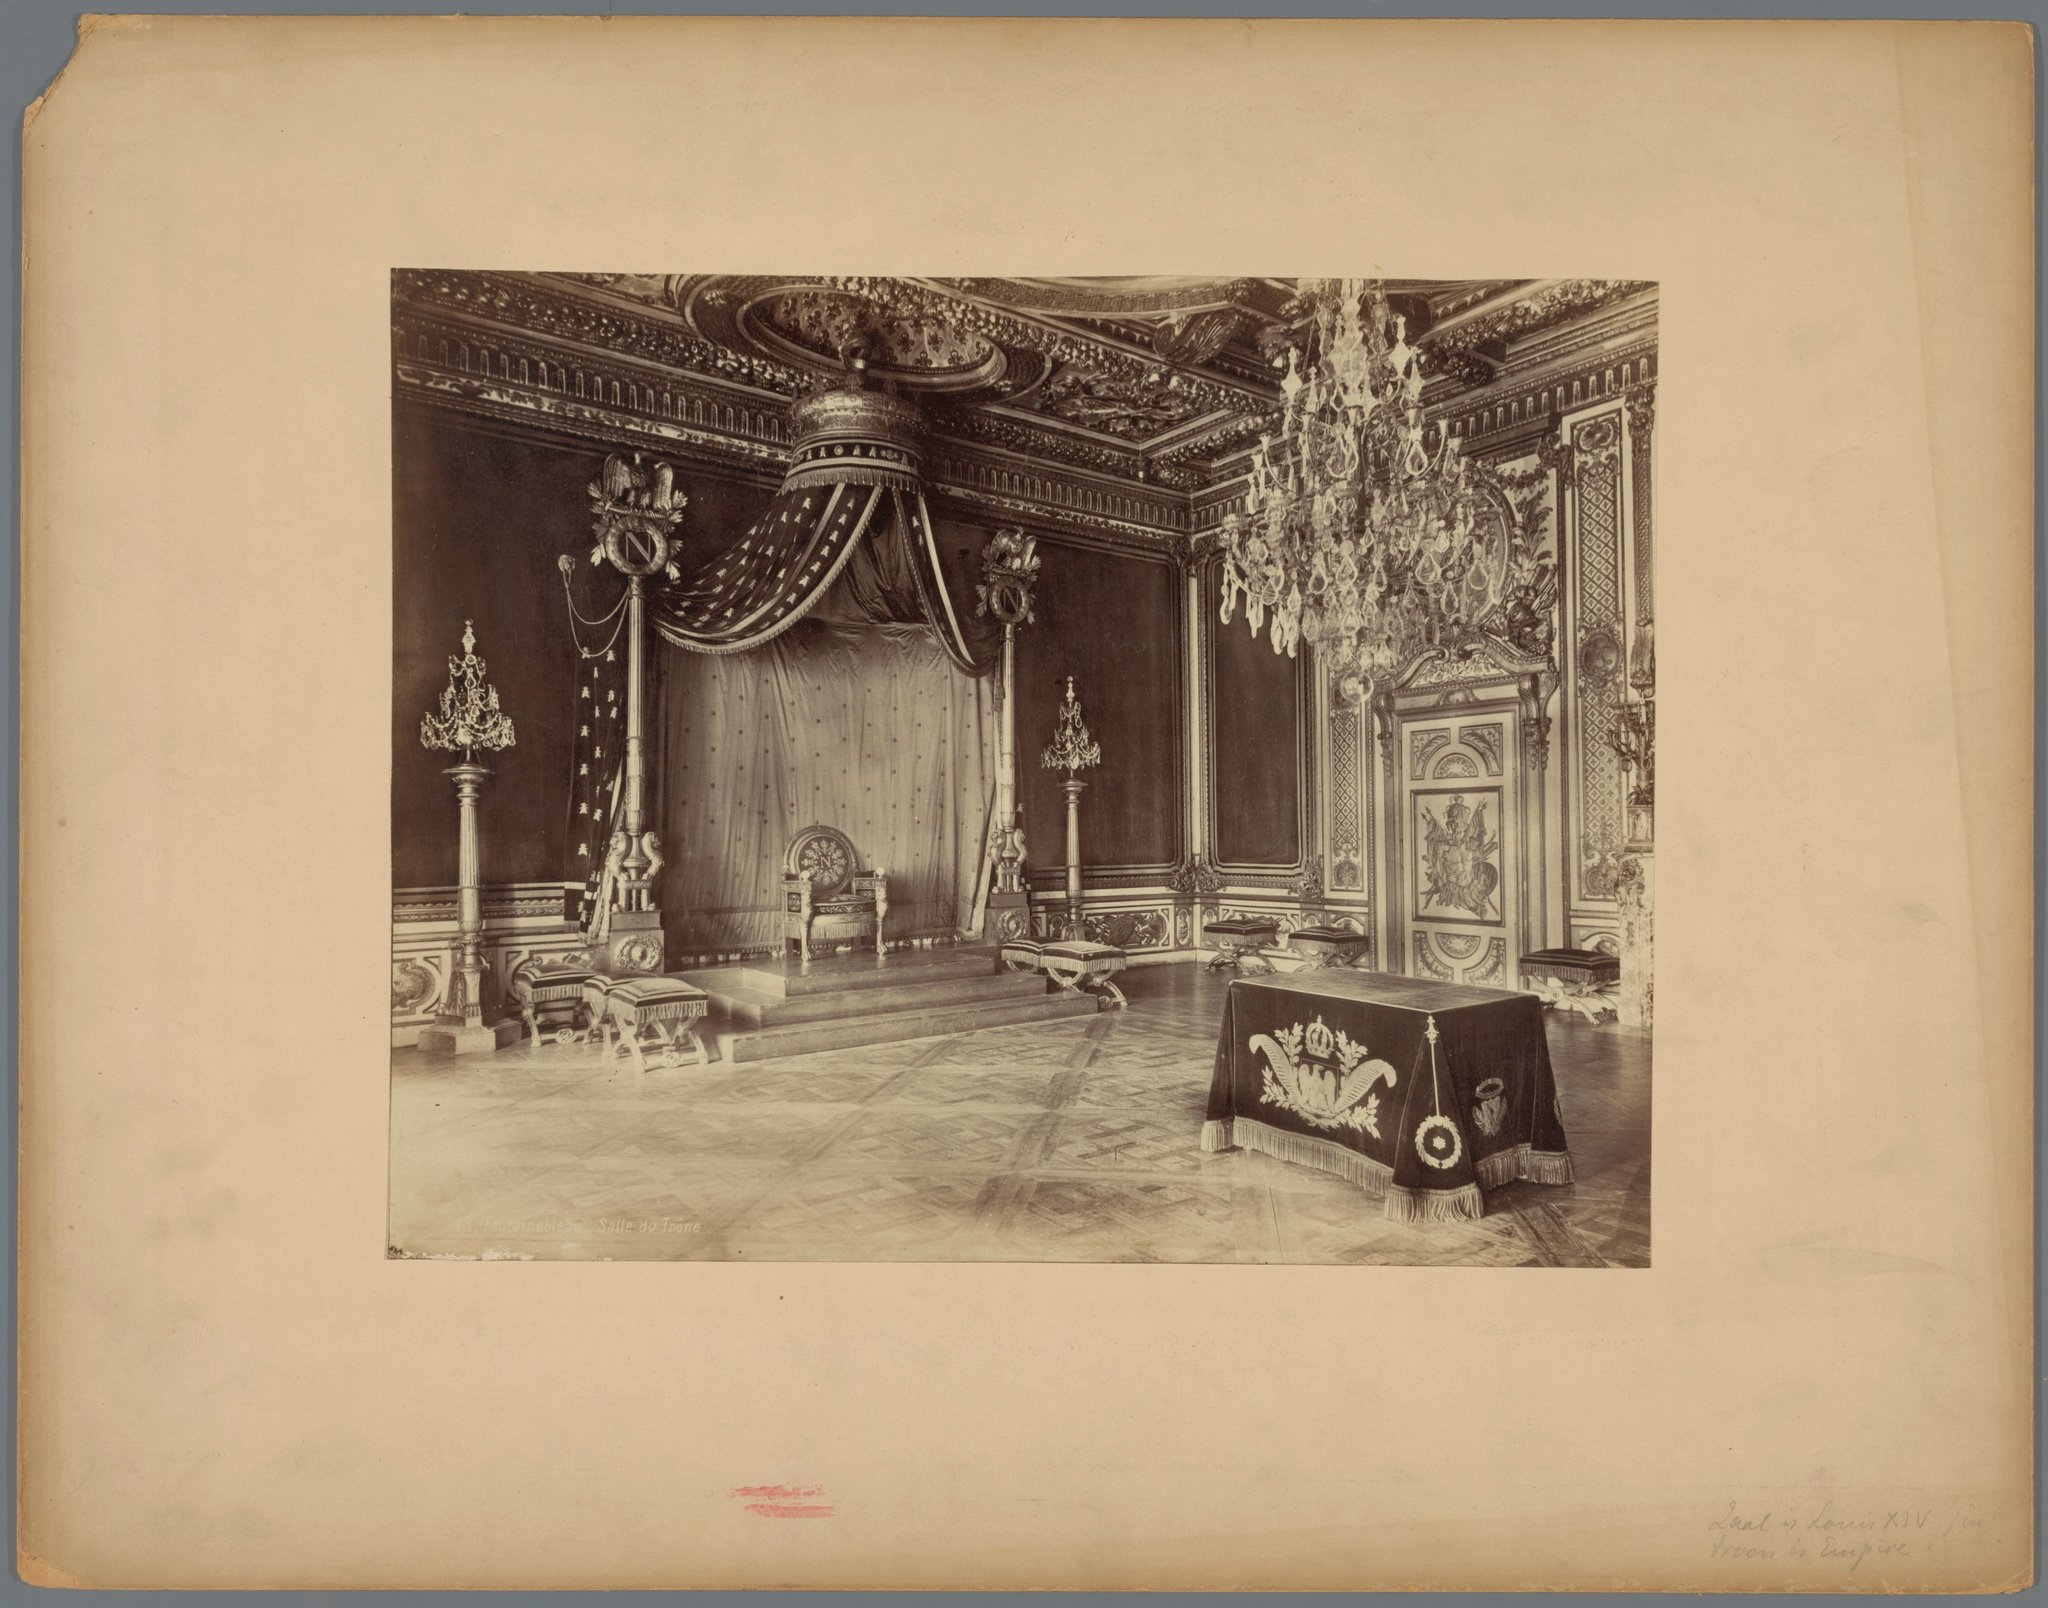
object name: photograph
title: Fontainebleau, - Salle de Bain.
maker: jd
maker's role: fotograaf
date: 1875-1900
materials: cardboard, photographic support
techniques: albumen print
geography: fontainebleau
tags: mirror, palace, interior of the house, chair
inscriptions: number: ‘15.’, collector's mark: Lugt 3937